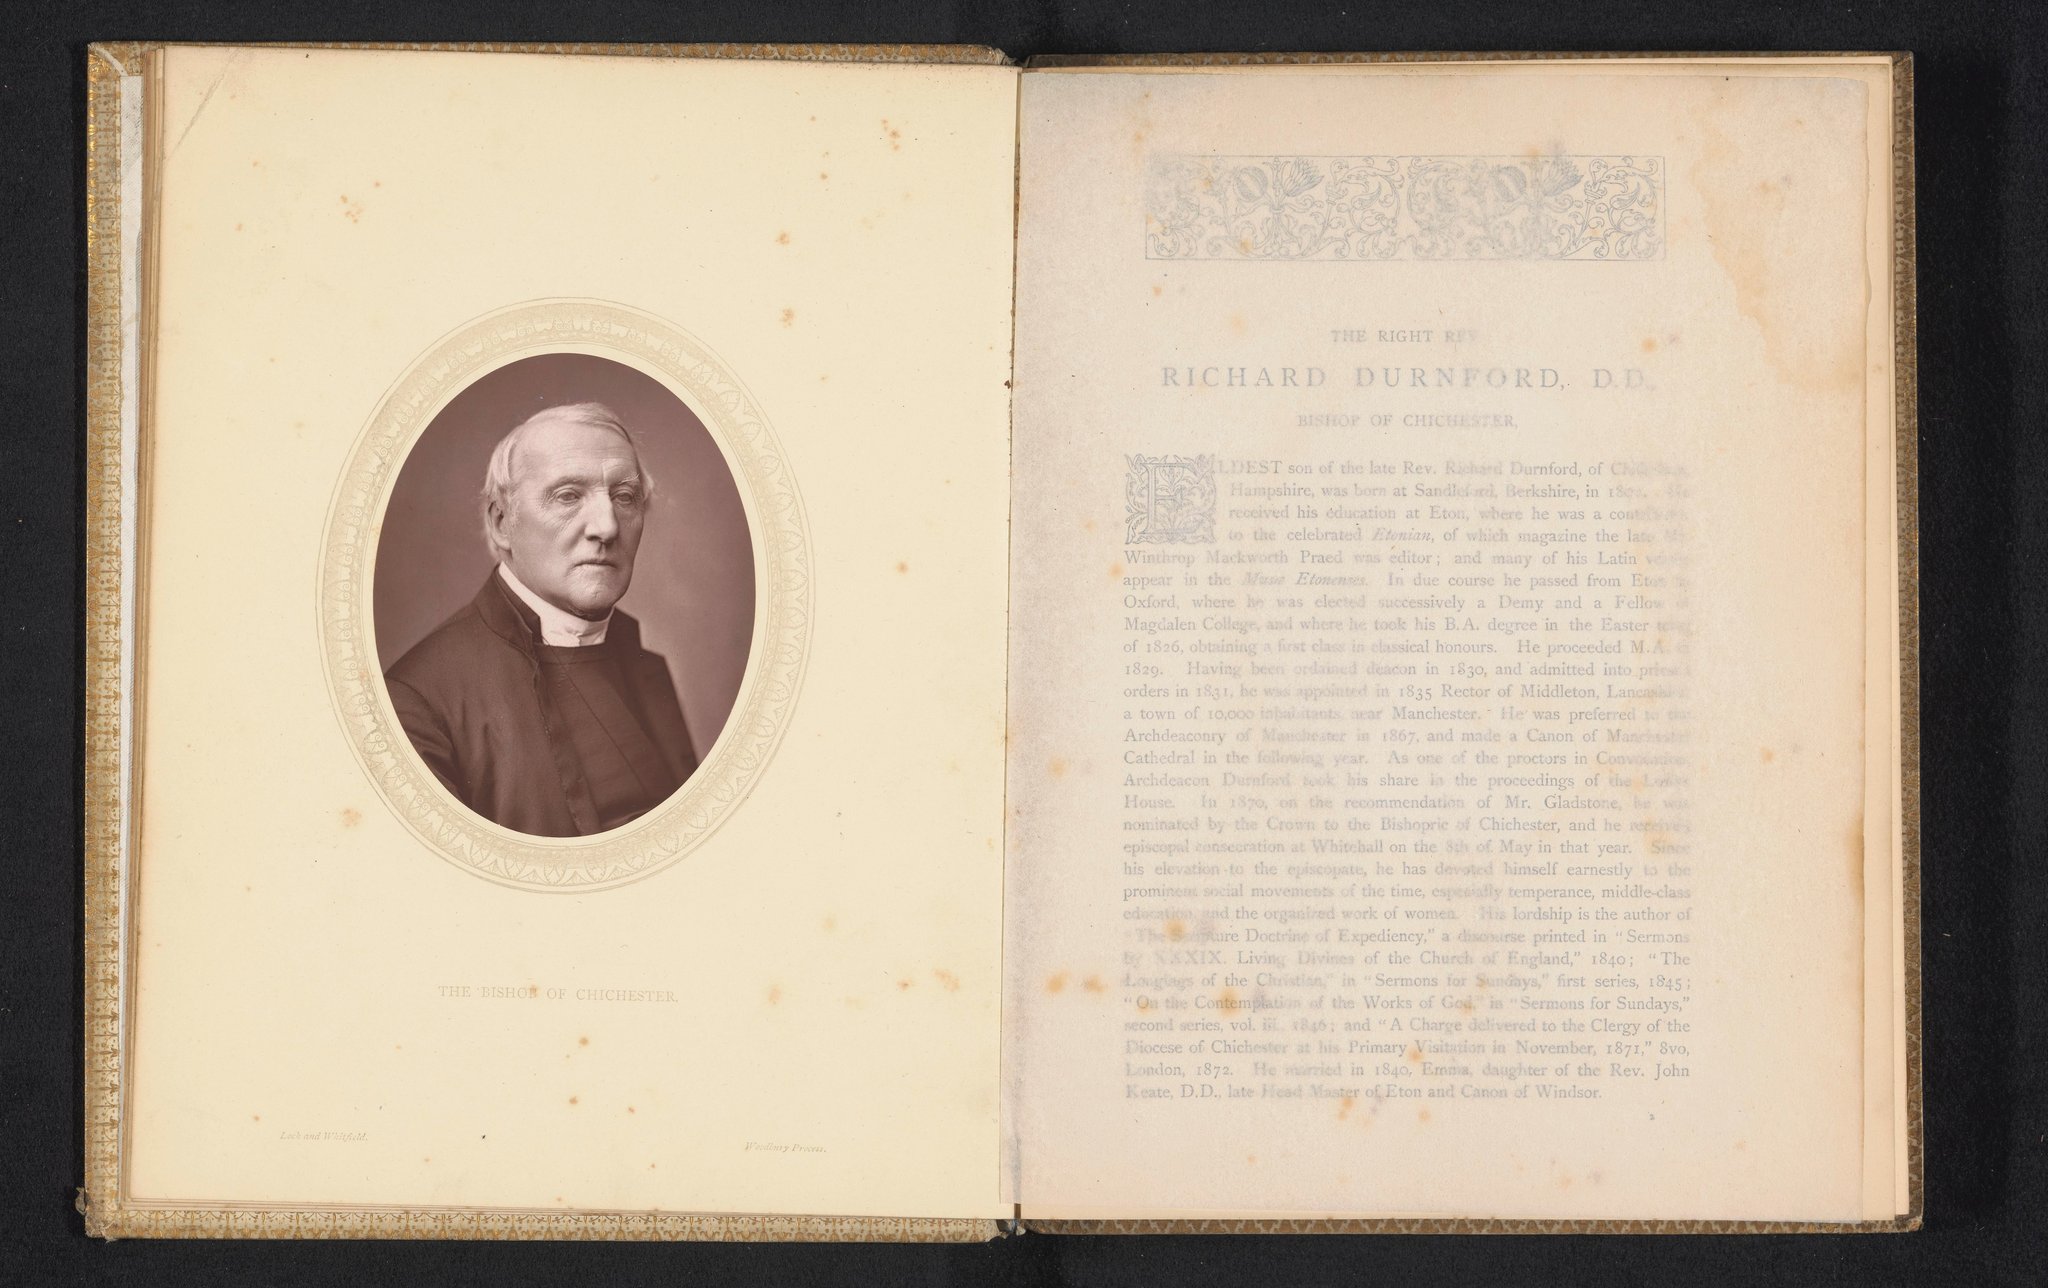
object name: photomechanical print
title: The bishop of Chichester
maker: Anonymous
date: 1871-1876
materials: paper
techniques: woodburytype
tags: archbishop, bishop, etc. (roman catholic), historical persons (portraits and scenes from the life) (+ (full) bust portrait)